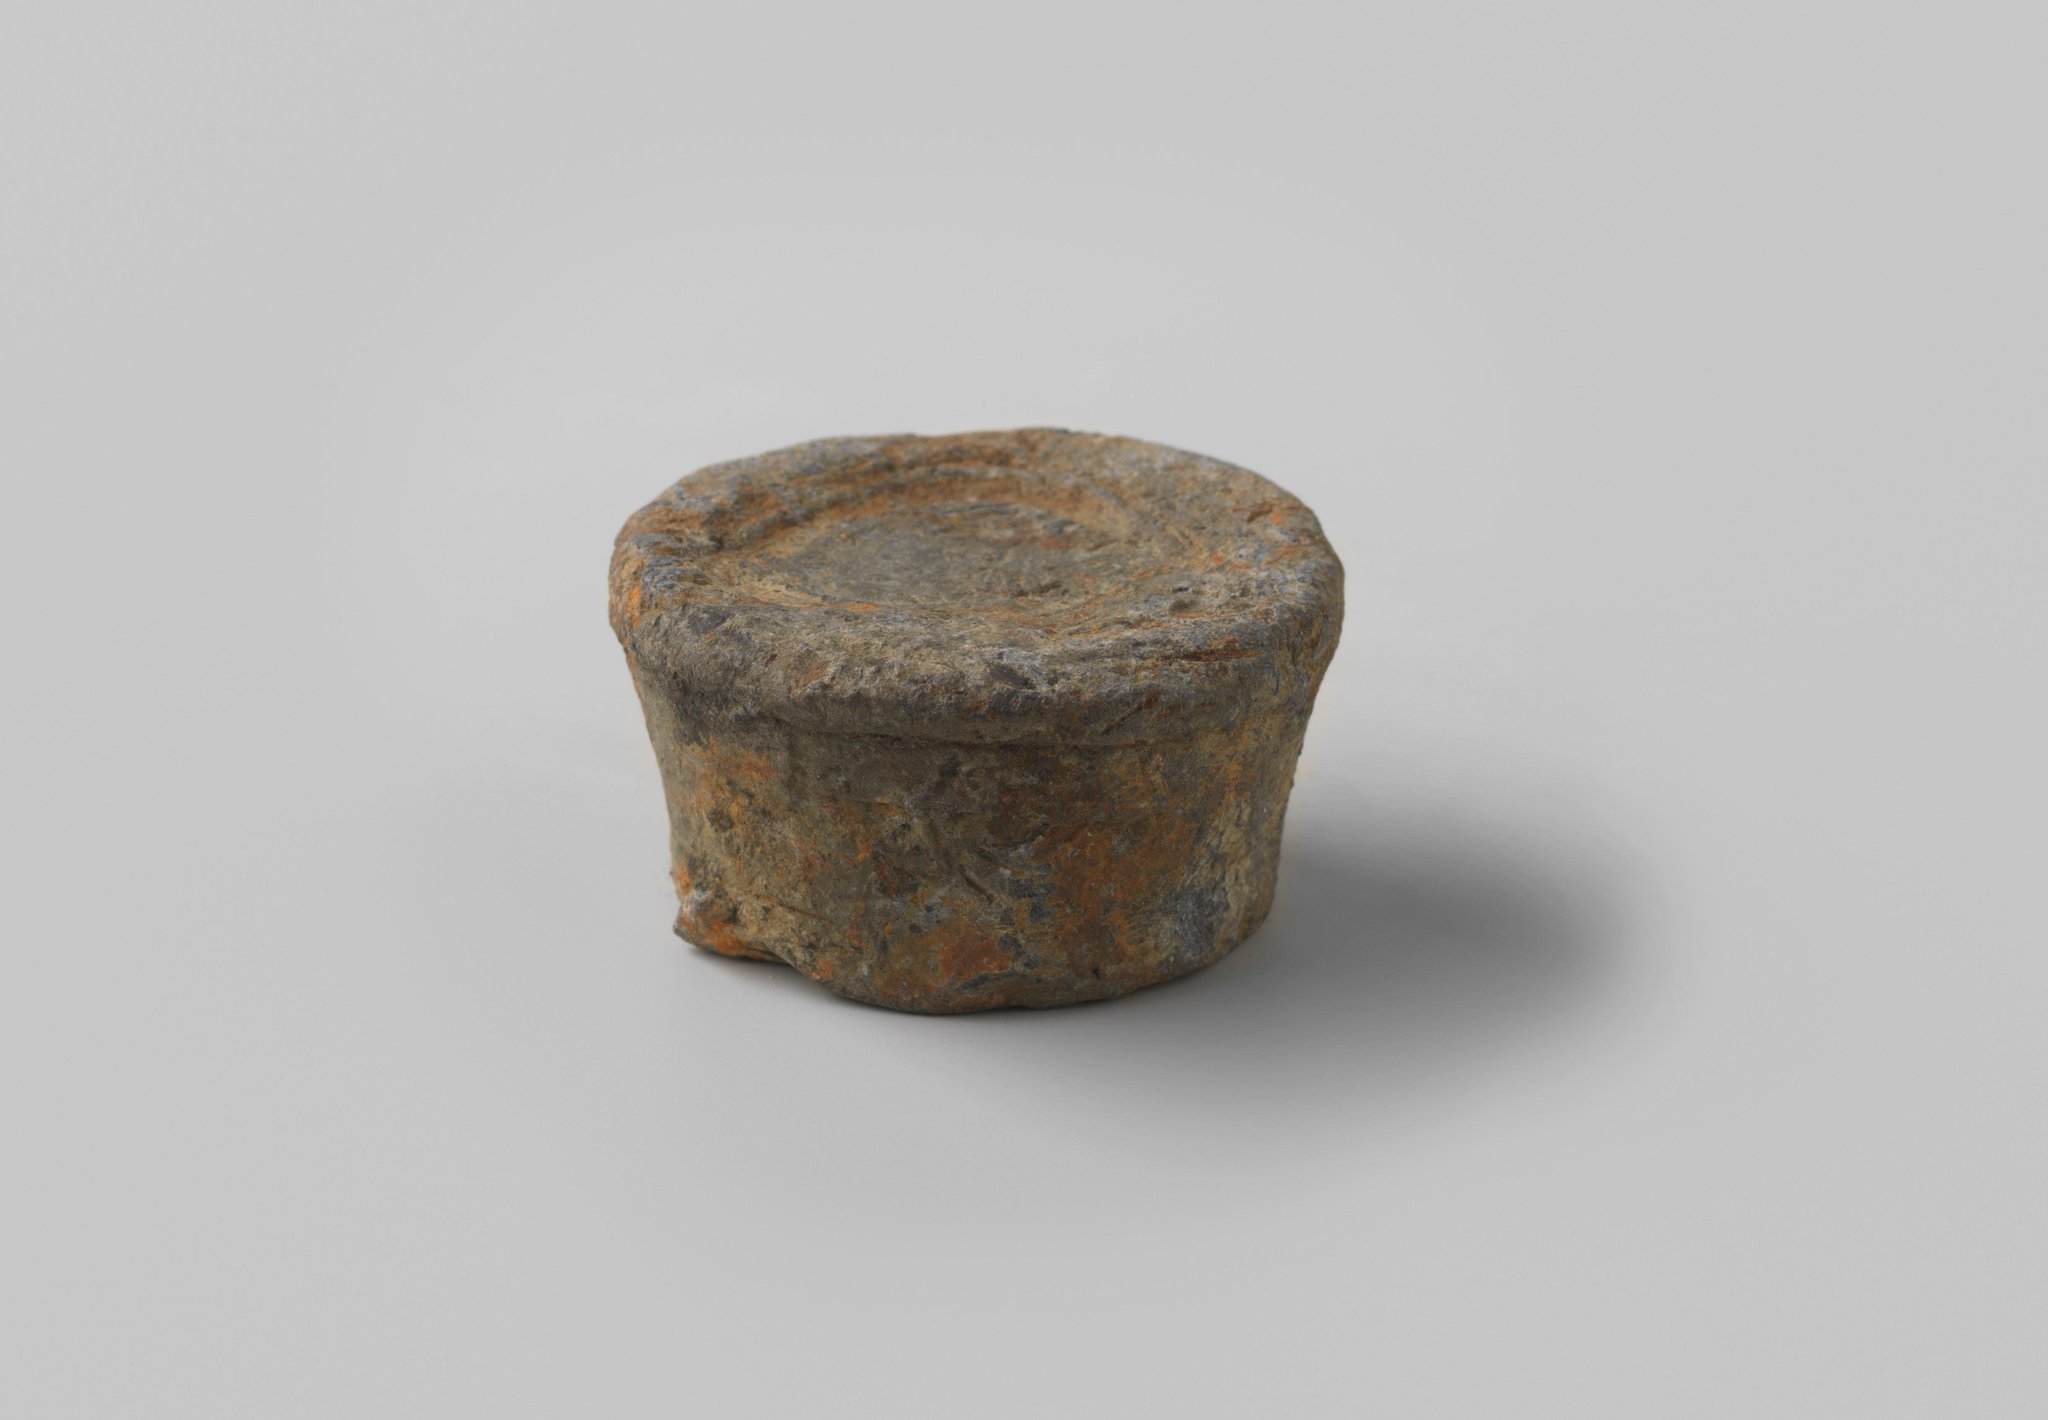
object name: weight scale component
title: Gewicht uit het wrak van de Oost-Indiëvaarder Meresteijn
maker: Anonymous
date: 1693-1702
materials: lead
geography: netherlands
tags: cape of good hope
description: Gewicht: rond massief taps toelopend blok metaal, onder en boven vlak. In de kraag zitten twee gaten en een onleesbaar merk in een rechthoek. Weight.